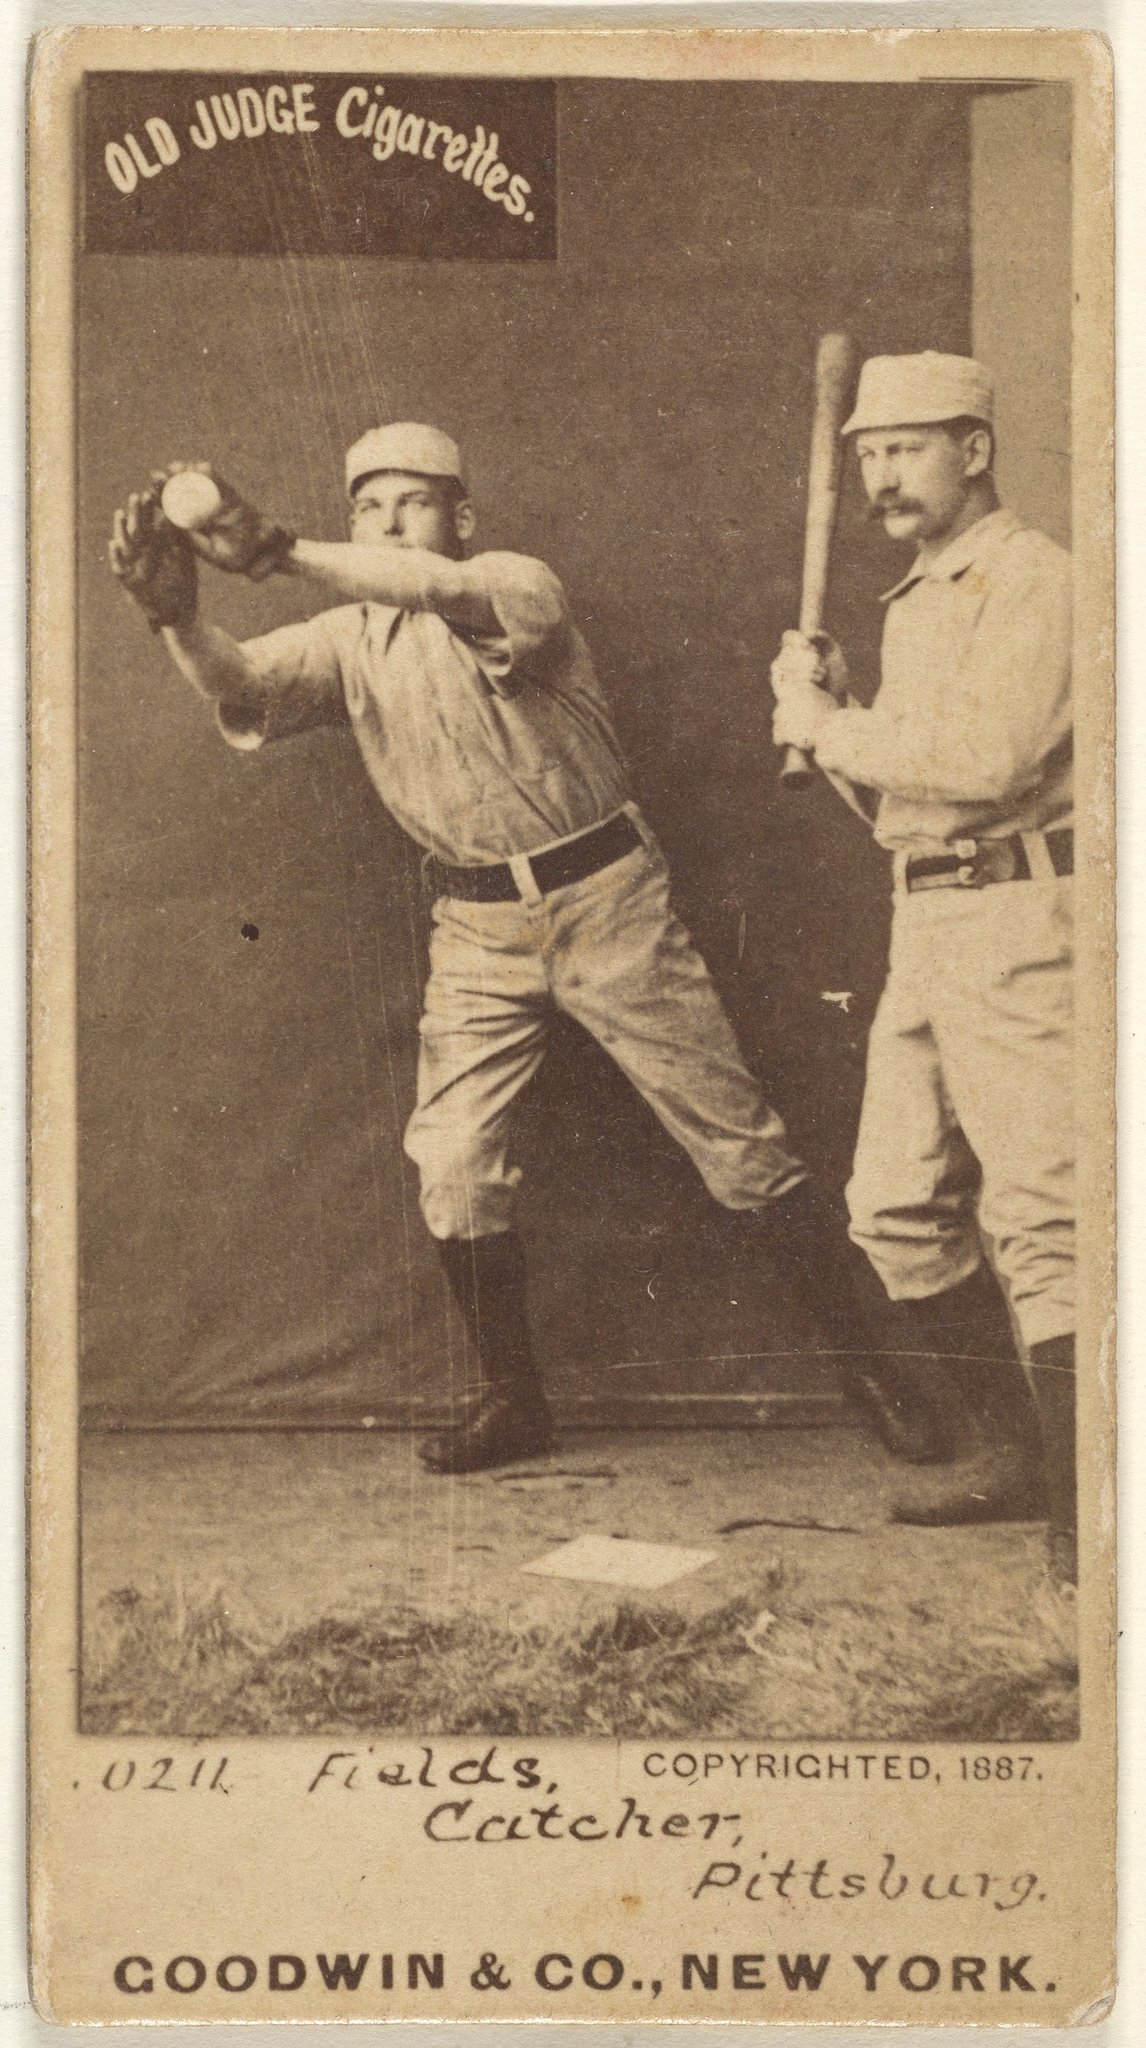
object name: baseball card, photograph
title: John Joseph "Jocko" Fields, Catcher, Pittsburgh, from the Old Judge series (N172) for Old Judge Cigarettes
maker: goodwin & company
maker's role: publisher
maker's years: 1850-1950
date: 1887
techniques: albumen silver print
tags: men,portraits,baseball,athletes